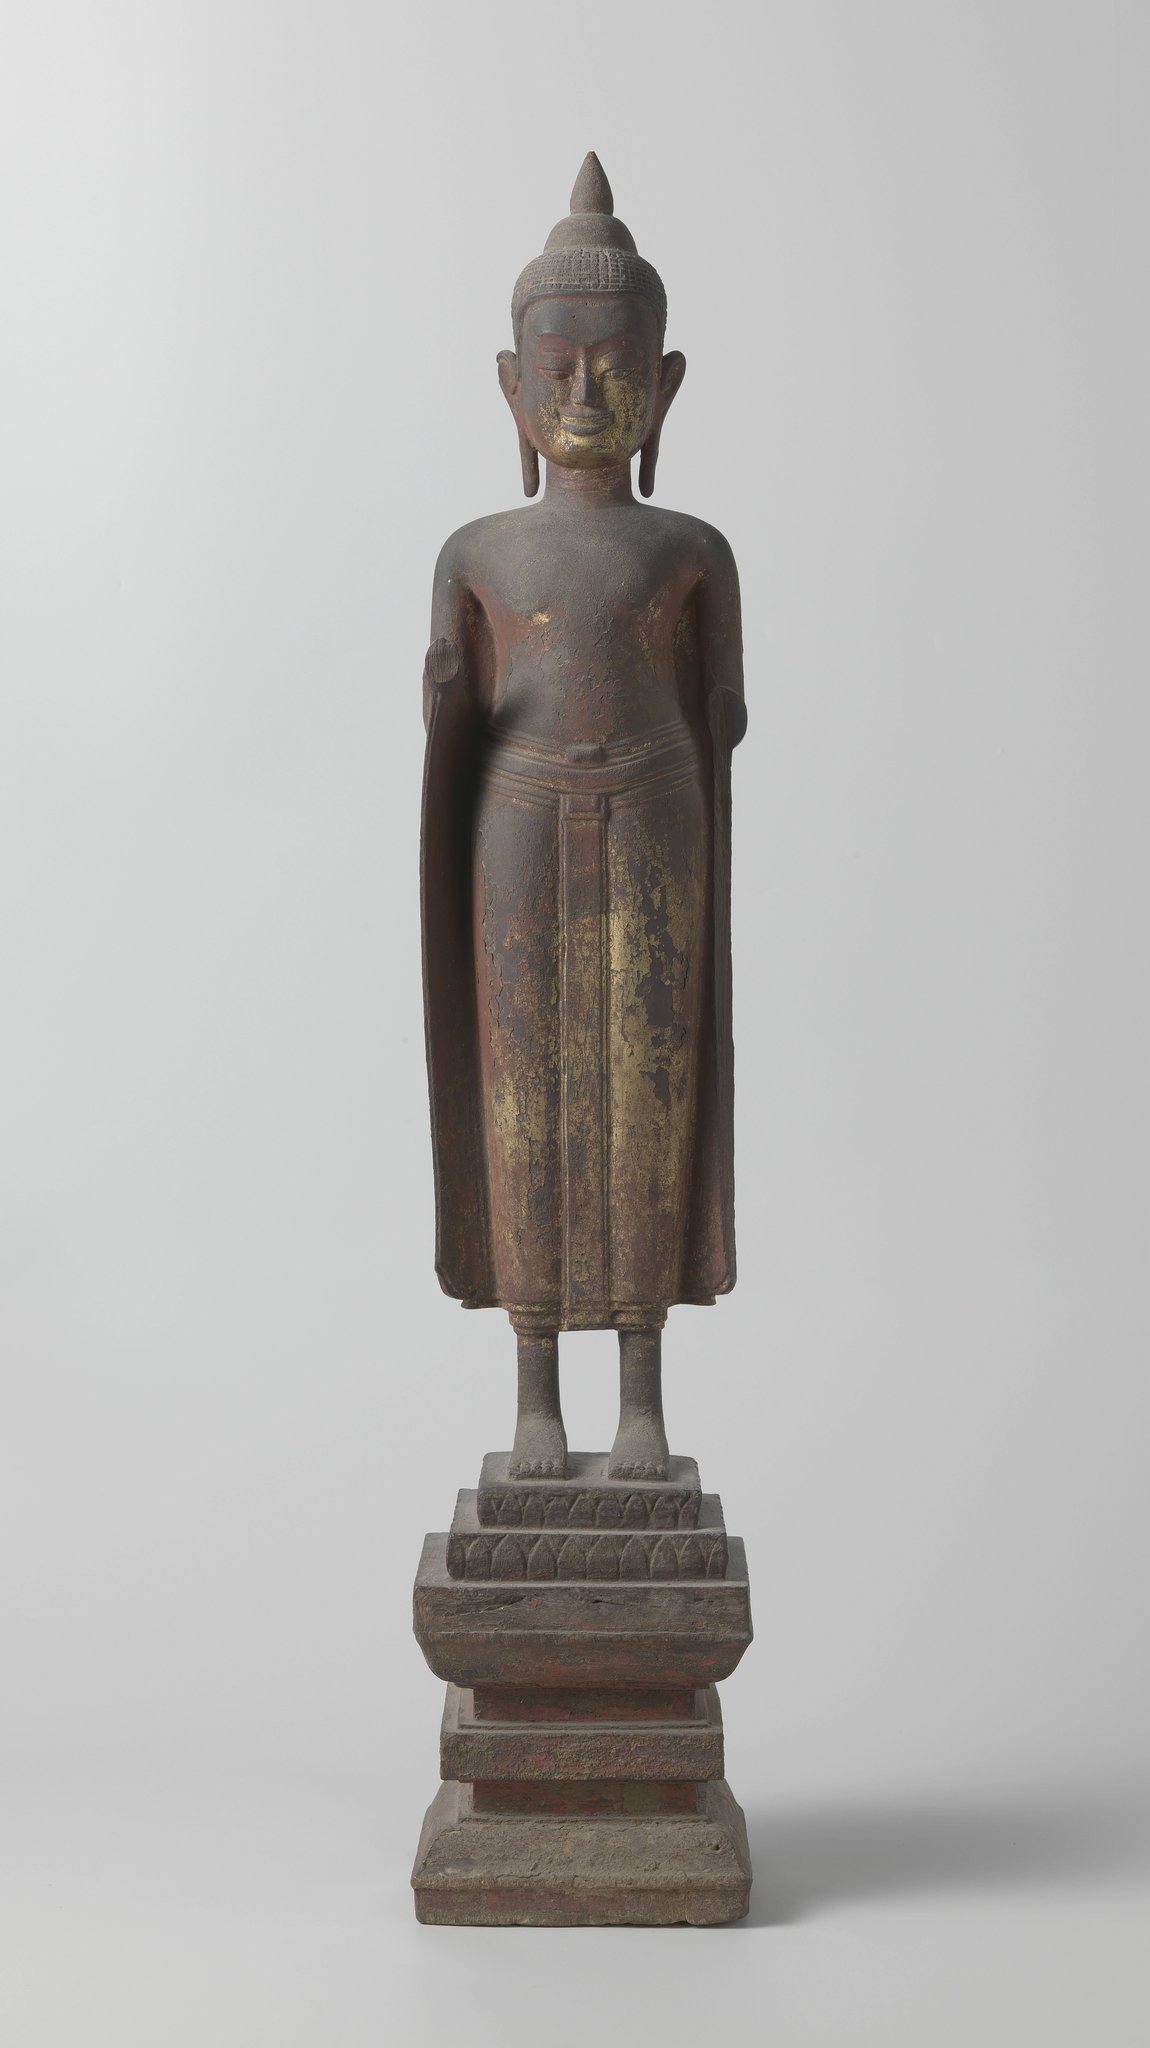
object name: sculpture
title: Boeddha op voetstuk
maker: Anonymous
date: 1400-1600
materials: wood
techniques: gilding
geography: cambodia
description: Boeddha staande op een voetstuk; handen en een gedeelte van de armen ontbreken.